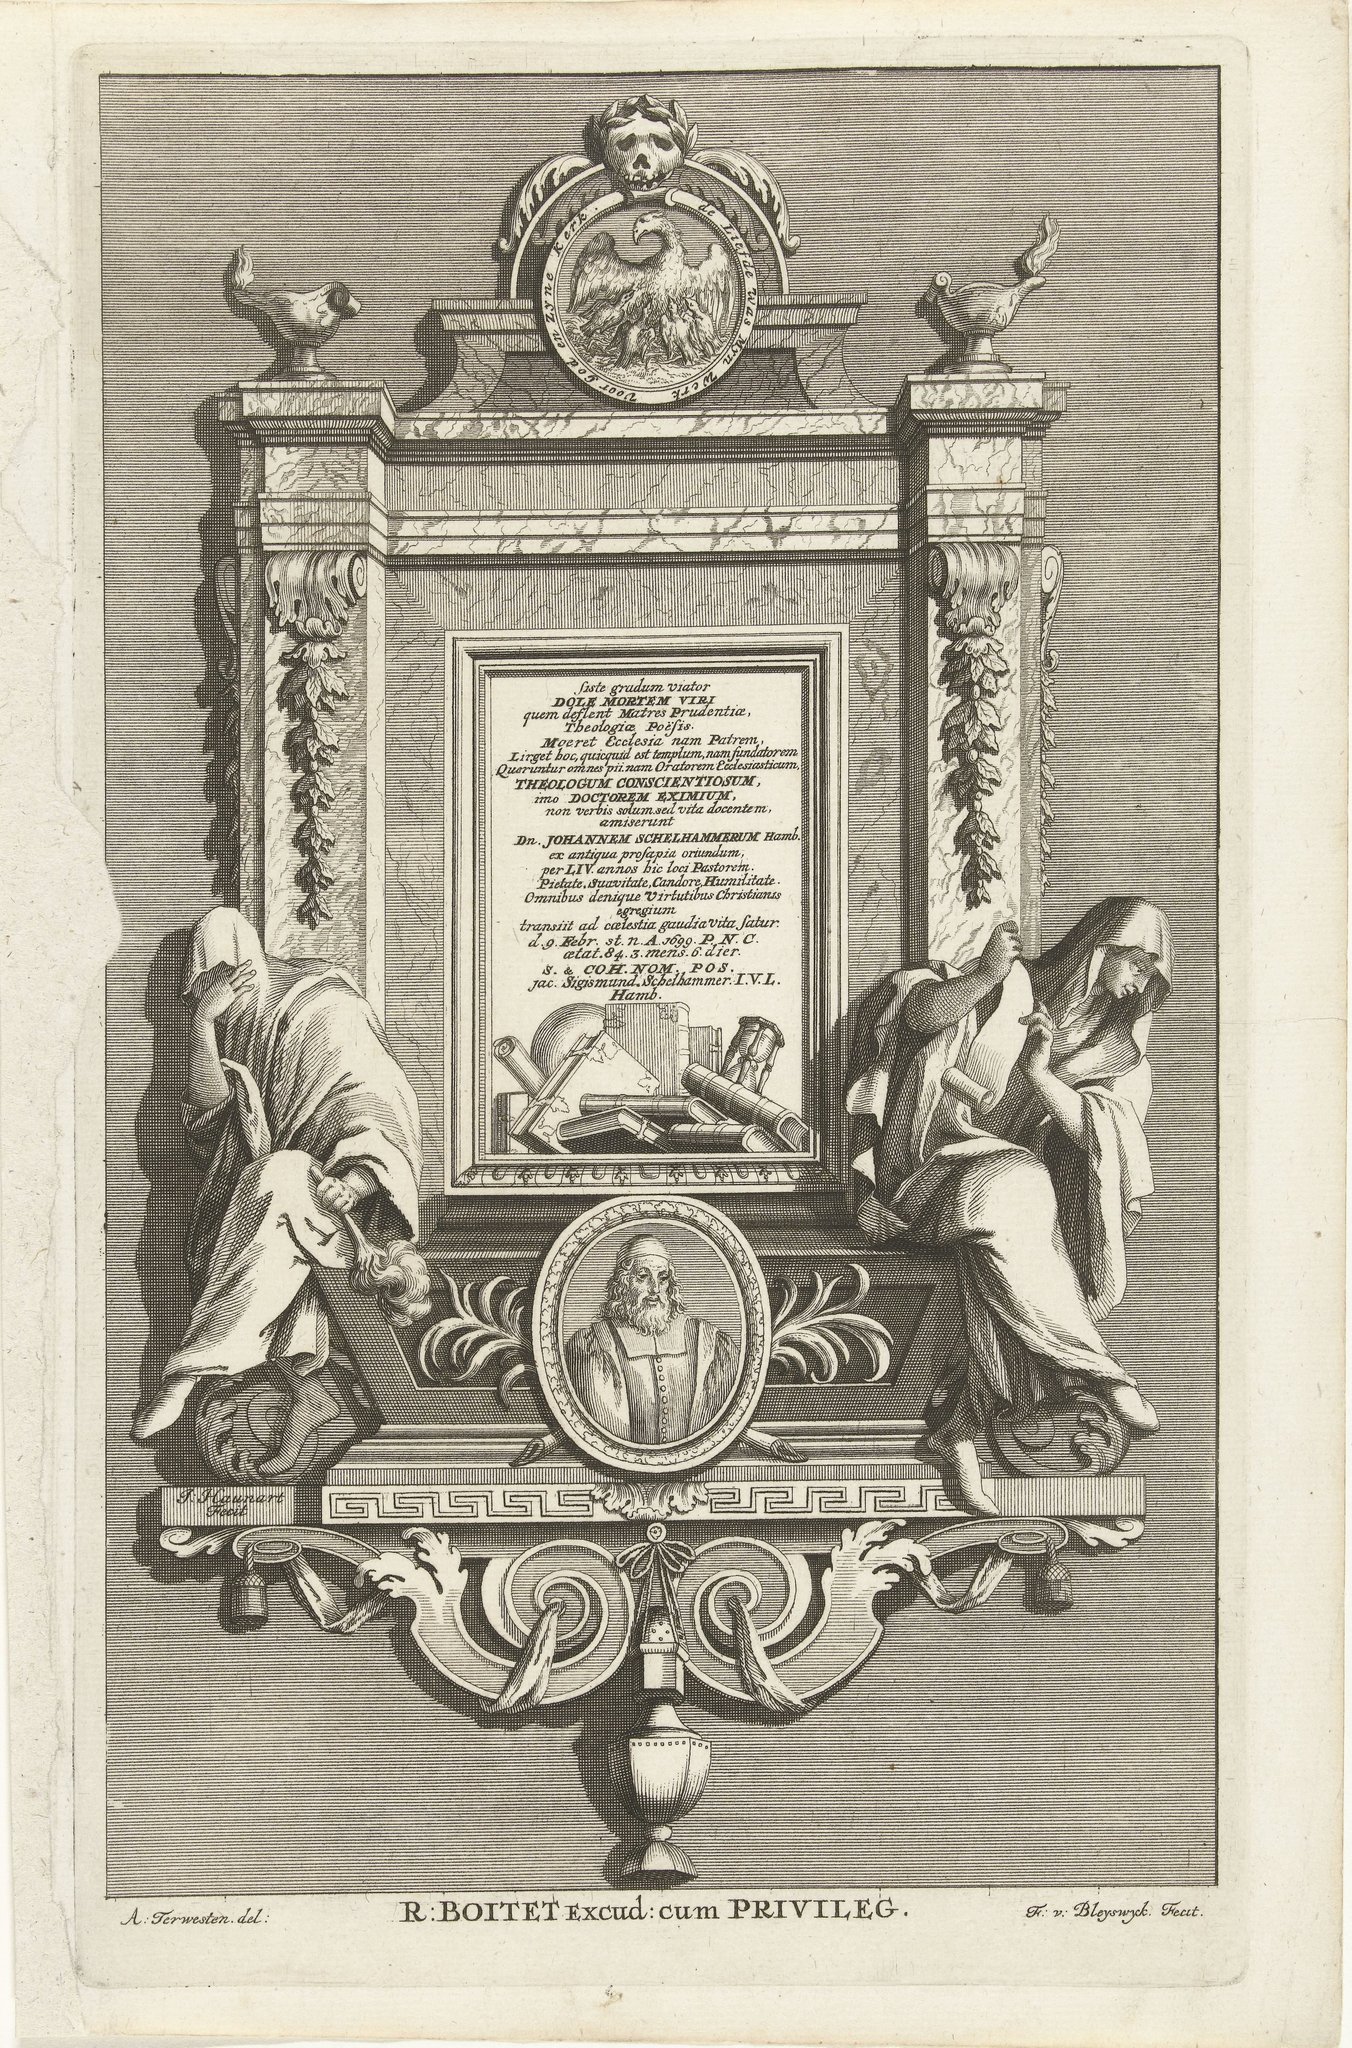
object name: book illustration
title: Grafmonument voor Johannes Schelhammer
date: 1730-1736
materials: paper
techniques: etching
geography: leiden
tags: the hague, johannes schelhammer, 'pleurants', epitaph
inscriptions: collector's mark: Lugt 2228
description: Grafmonument of epitaaf voor Duitse theoloog Johannes Schelhammer in de Evangelisch Lutherse kerk aan de Lutherse Burgwal te Den Haag. Een plaat met Latijns opschrift ter nagedachtenis aan hem is het middelpunt van een architecturale omlijsting. Deze wordt bekroond met een medaillon waarop het symbool van Christus' lijden is afgebeeld: een pelikaan voedt haar jongen met haar eigen bloed. Twee treurende vrouwen flankeren een portret van Schelhammer.